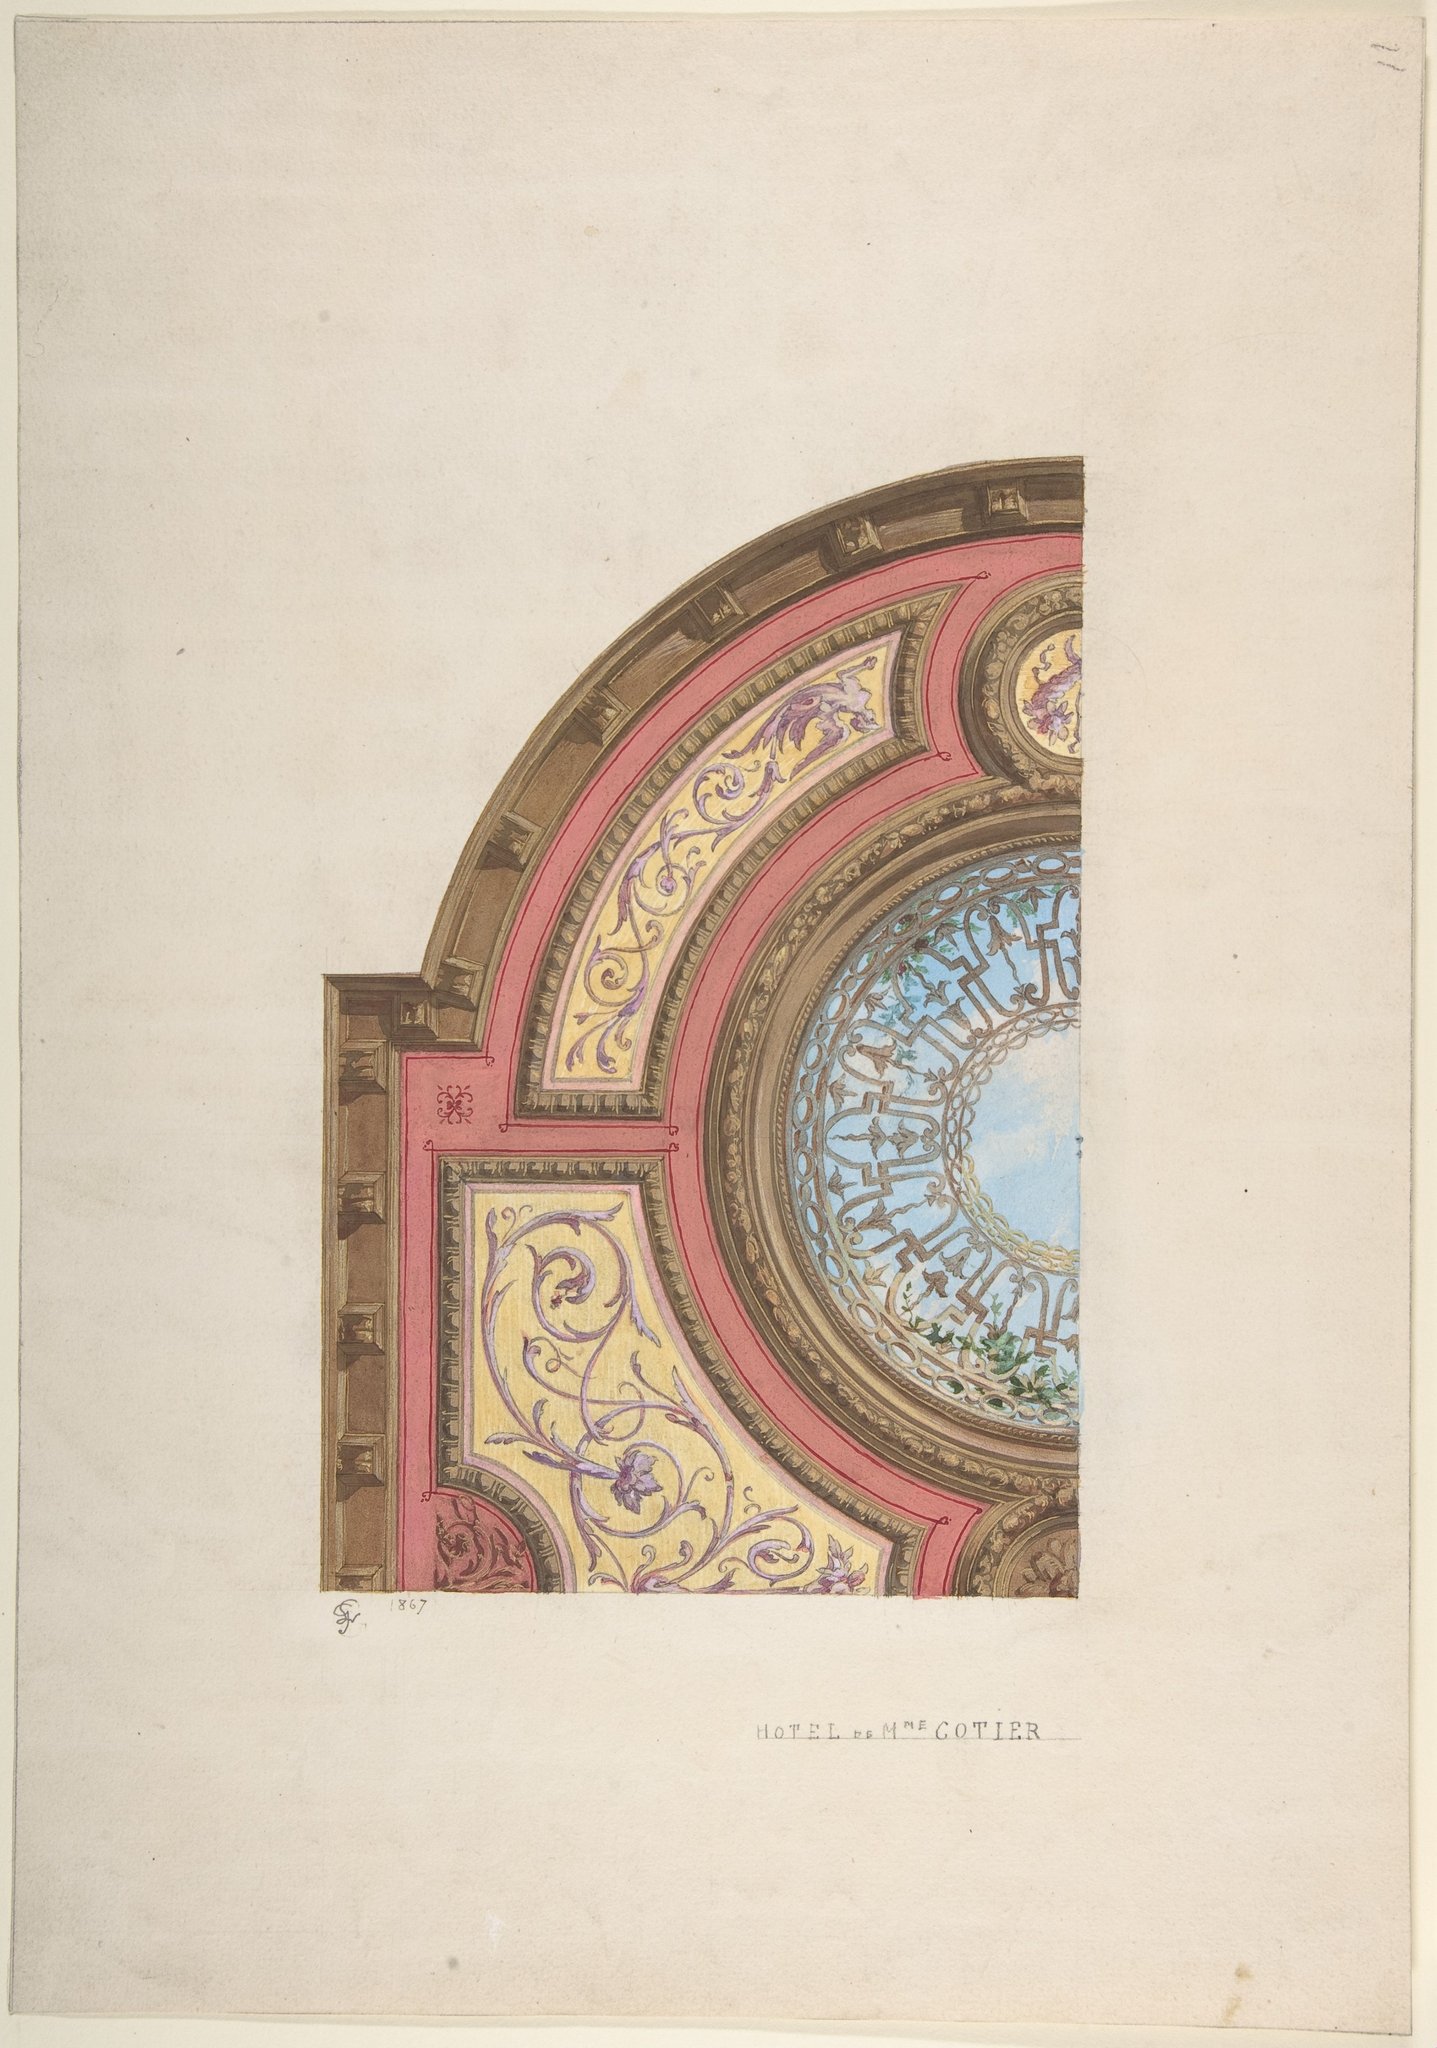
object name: drawing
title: Design for Ceiling, Hôtel Cottier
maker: jules-edmond-charles lachaise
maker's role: artist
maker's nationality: french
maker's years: 1897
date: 1879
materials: gilt, gouache, watercolor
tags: ceilings